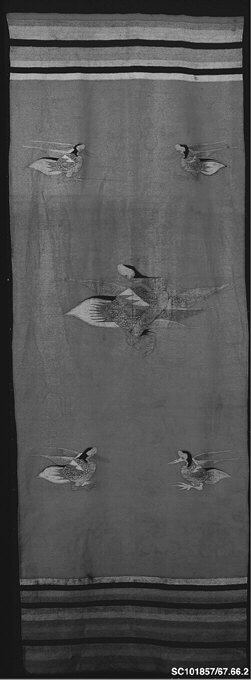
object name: rug or hanging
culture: chinese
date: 1801-1900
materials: cotton, hair, wool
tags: geese